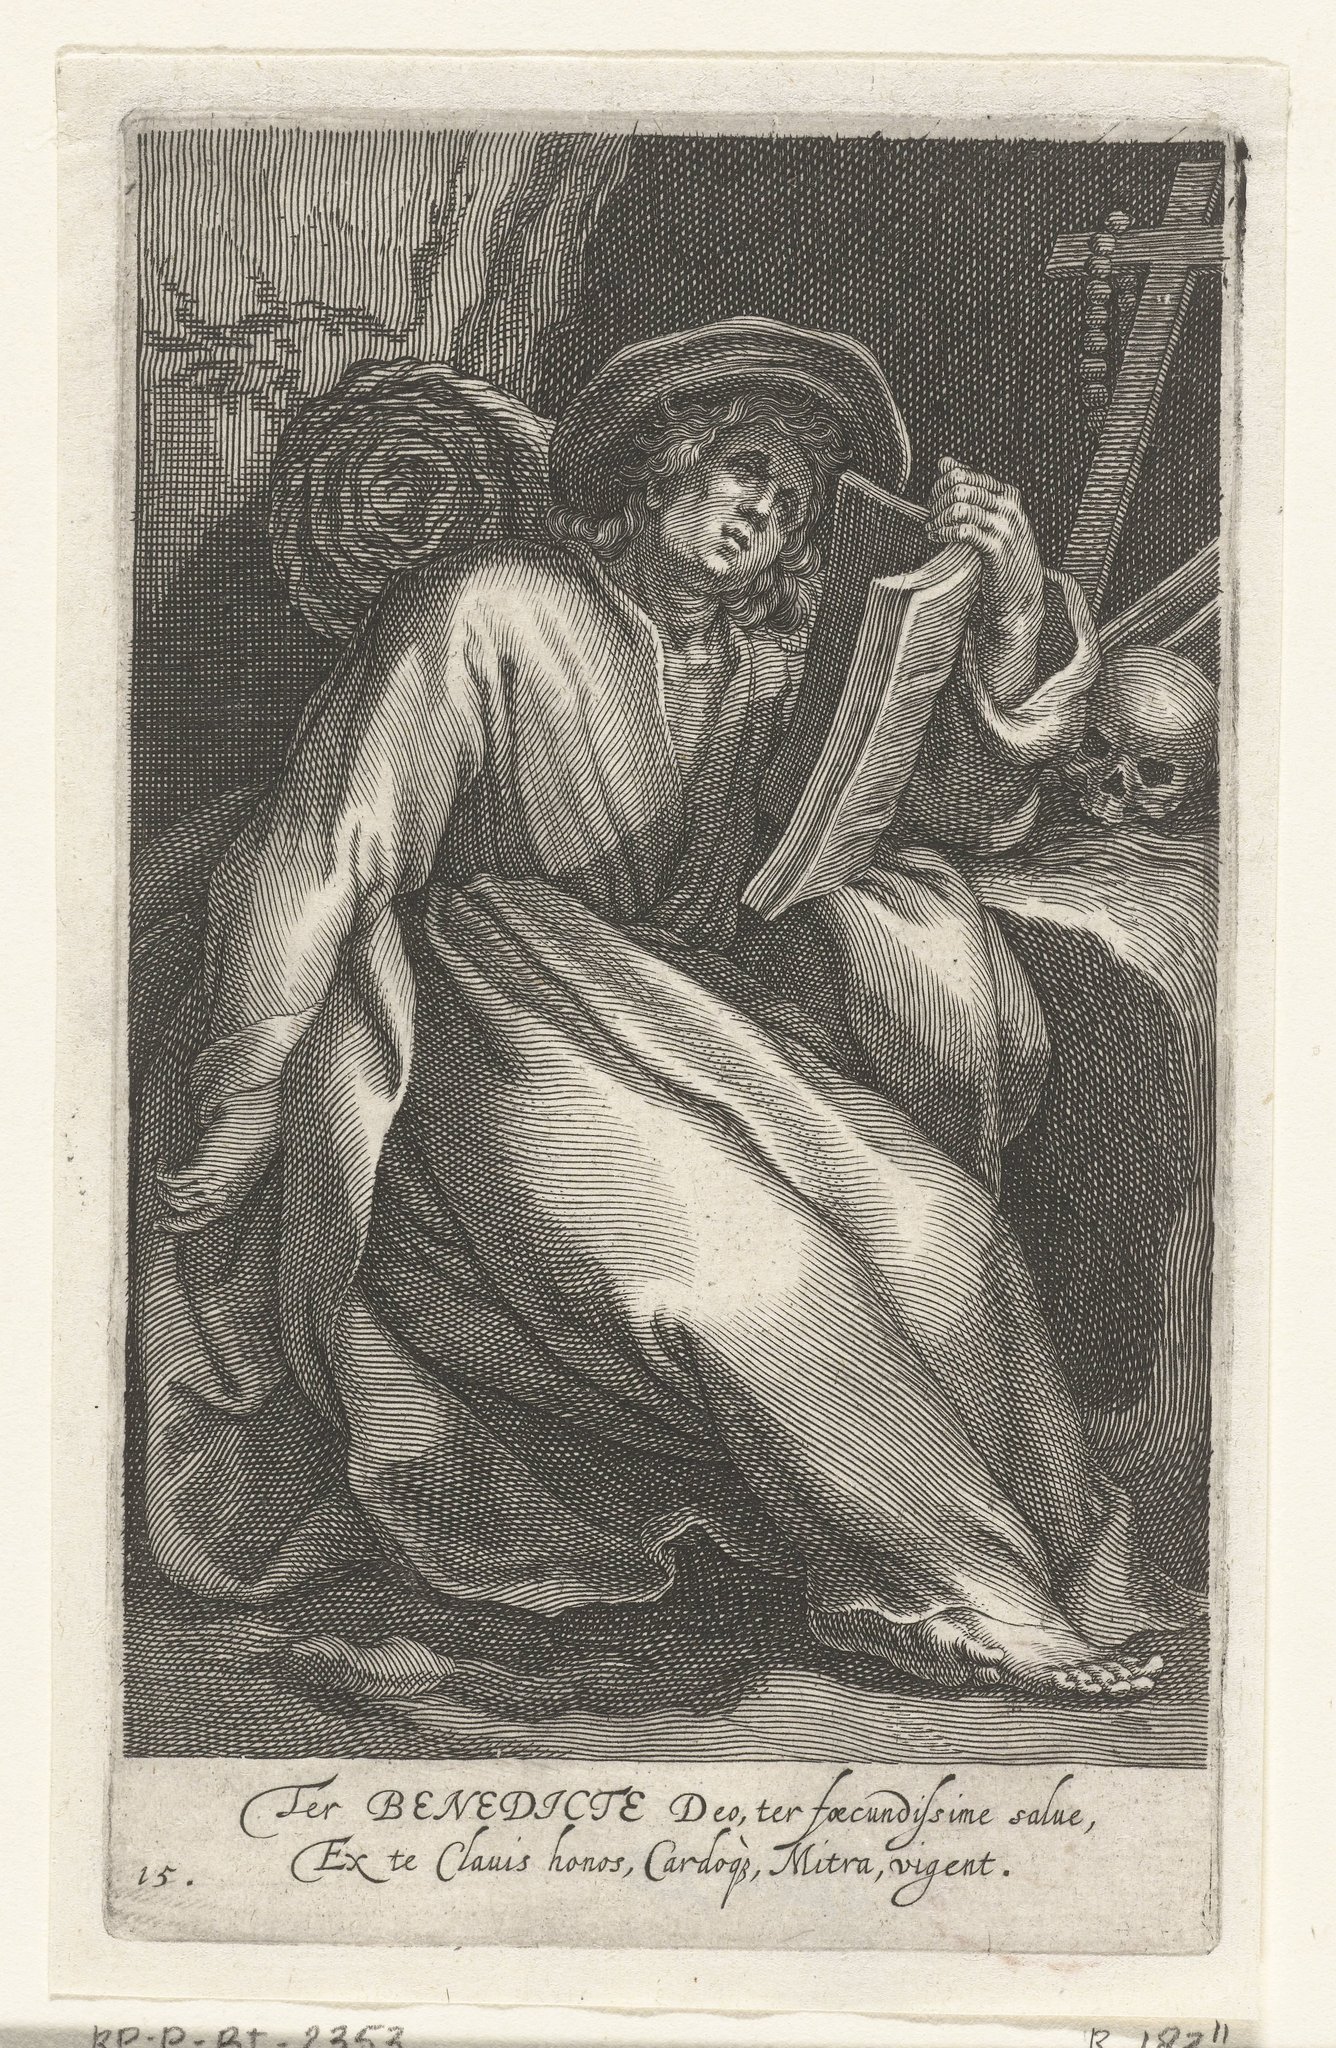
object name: print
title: Heilige Benedictus van Nursia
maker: boëtius adamsz. bolswert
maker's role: print maker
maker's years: 1580-1633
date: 1590-1612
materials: paper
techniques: engraving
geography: amsterdam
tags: benedict of nurcia, abbot of monte cassino and founder of the benedictine order; possible attributes: aspergillum, book, cup (sometimes broken), raven with loaf, sieve (or tray)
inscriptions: collector's mark: Lugt 240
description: Prent uit: Ad sacrum speculum recurris? ... patribus dat ales, geen plaats, Boëtius Adamsz. Bolswert, 1612. Tweede ongebonden uitgave met in totaal vijftig prenten. Prent uit serie van drieentwintig mannelijke kluizenaars. In 1619 verscheen een gebonden editie maar op basis van de gewijzigde opschriften en samenstelling wordt aangenomen dat deze prenten ook in 1612 of iets daarvoor gedrukt werden. Roethlisberger beschouwt de uitgave van 1619 als de eerste staat en de ongebonden editie van 1612 als de tweede staat (Roethlisberger 1993, p. 171, 172).